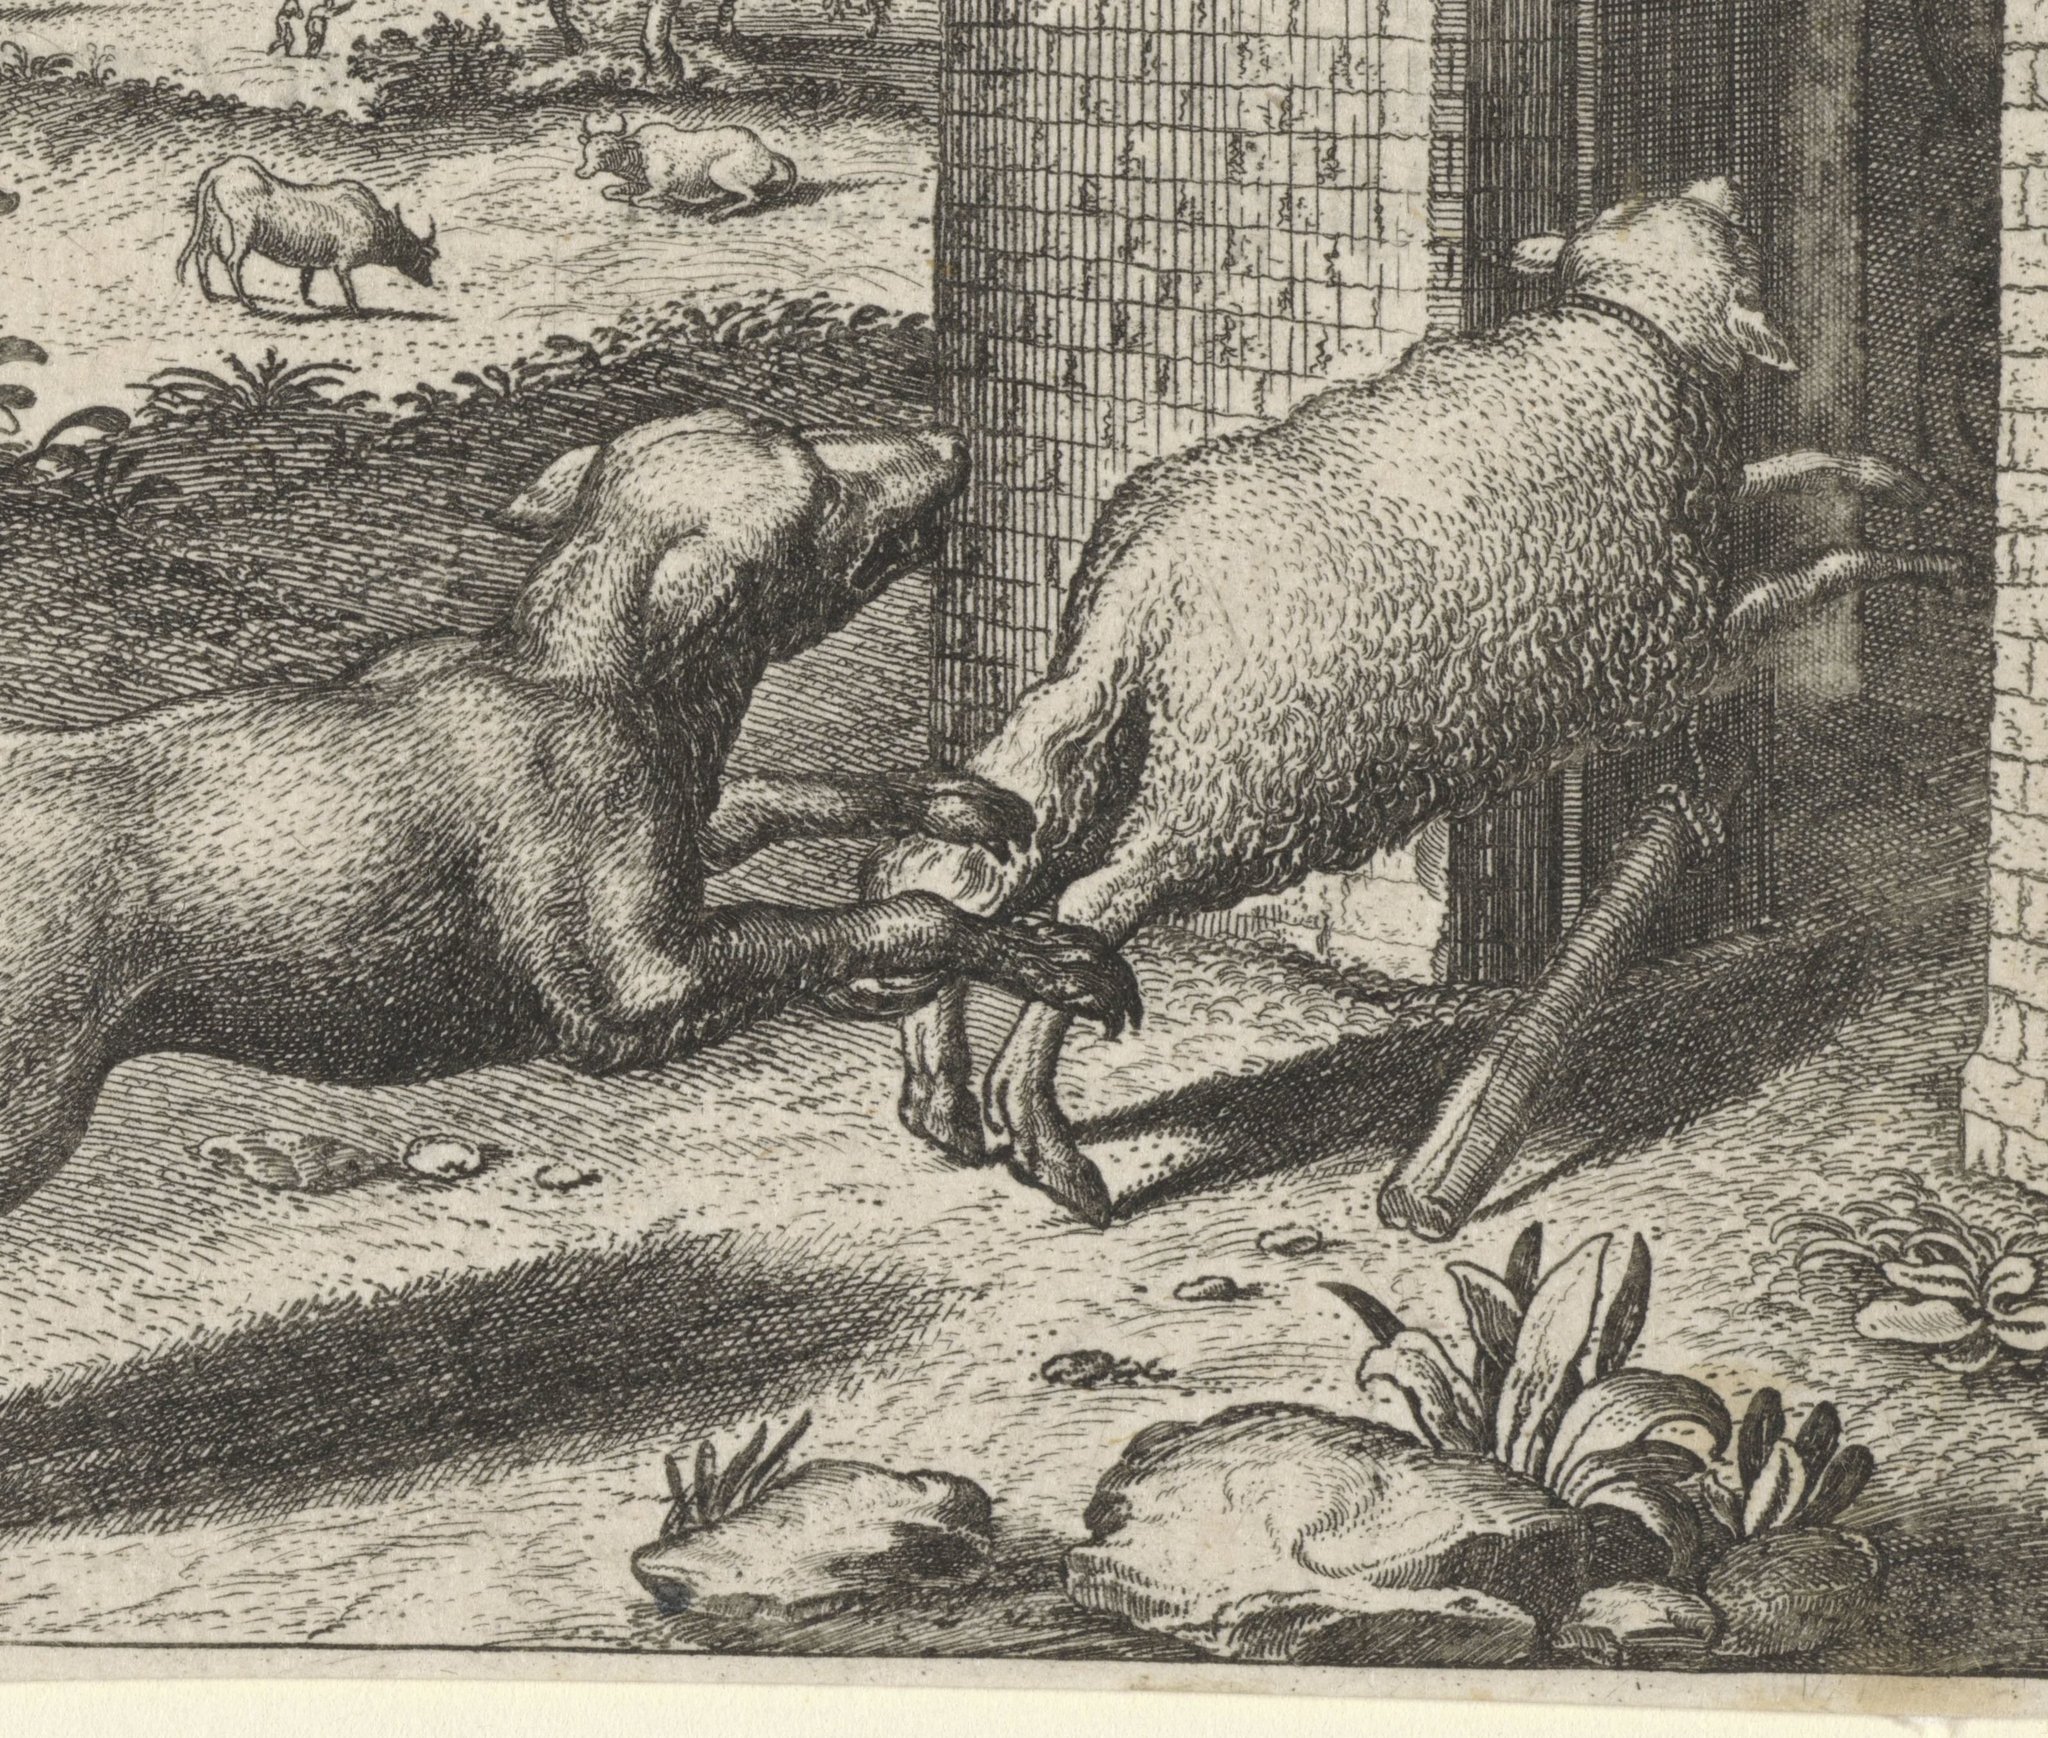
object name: book illustration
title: Fabel van de wolf en het schaap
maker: aegidius sadeler (ii)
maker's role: draughtsman, print maker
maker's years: 1568-1629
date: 1608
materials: paper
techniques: engraving, etching, letterpress printing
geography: prague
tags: sheep, fables, church (exterior) - qq - small church, chapel, beasts of prey, predatory animals: wolf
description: Een schaap rent een kerk binnen, gevolgd door een wolf. De fabel beschrijft hoe een wolf een schaap achtervolgt en opgesloten wordt in een kerk. De moraal van het verhaal leert dat men beter zijn lusten kan bedwingen.